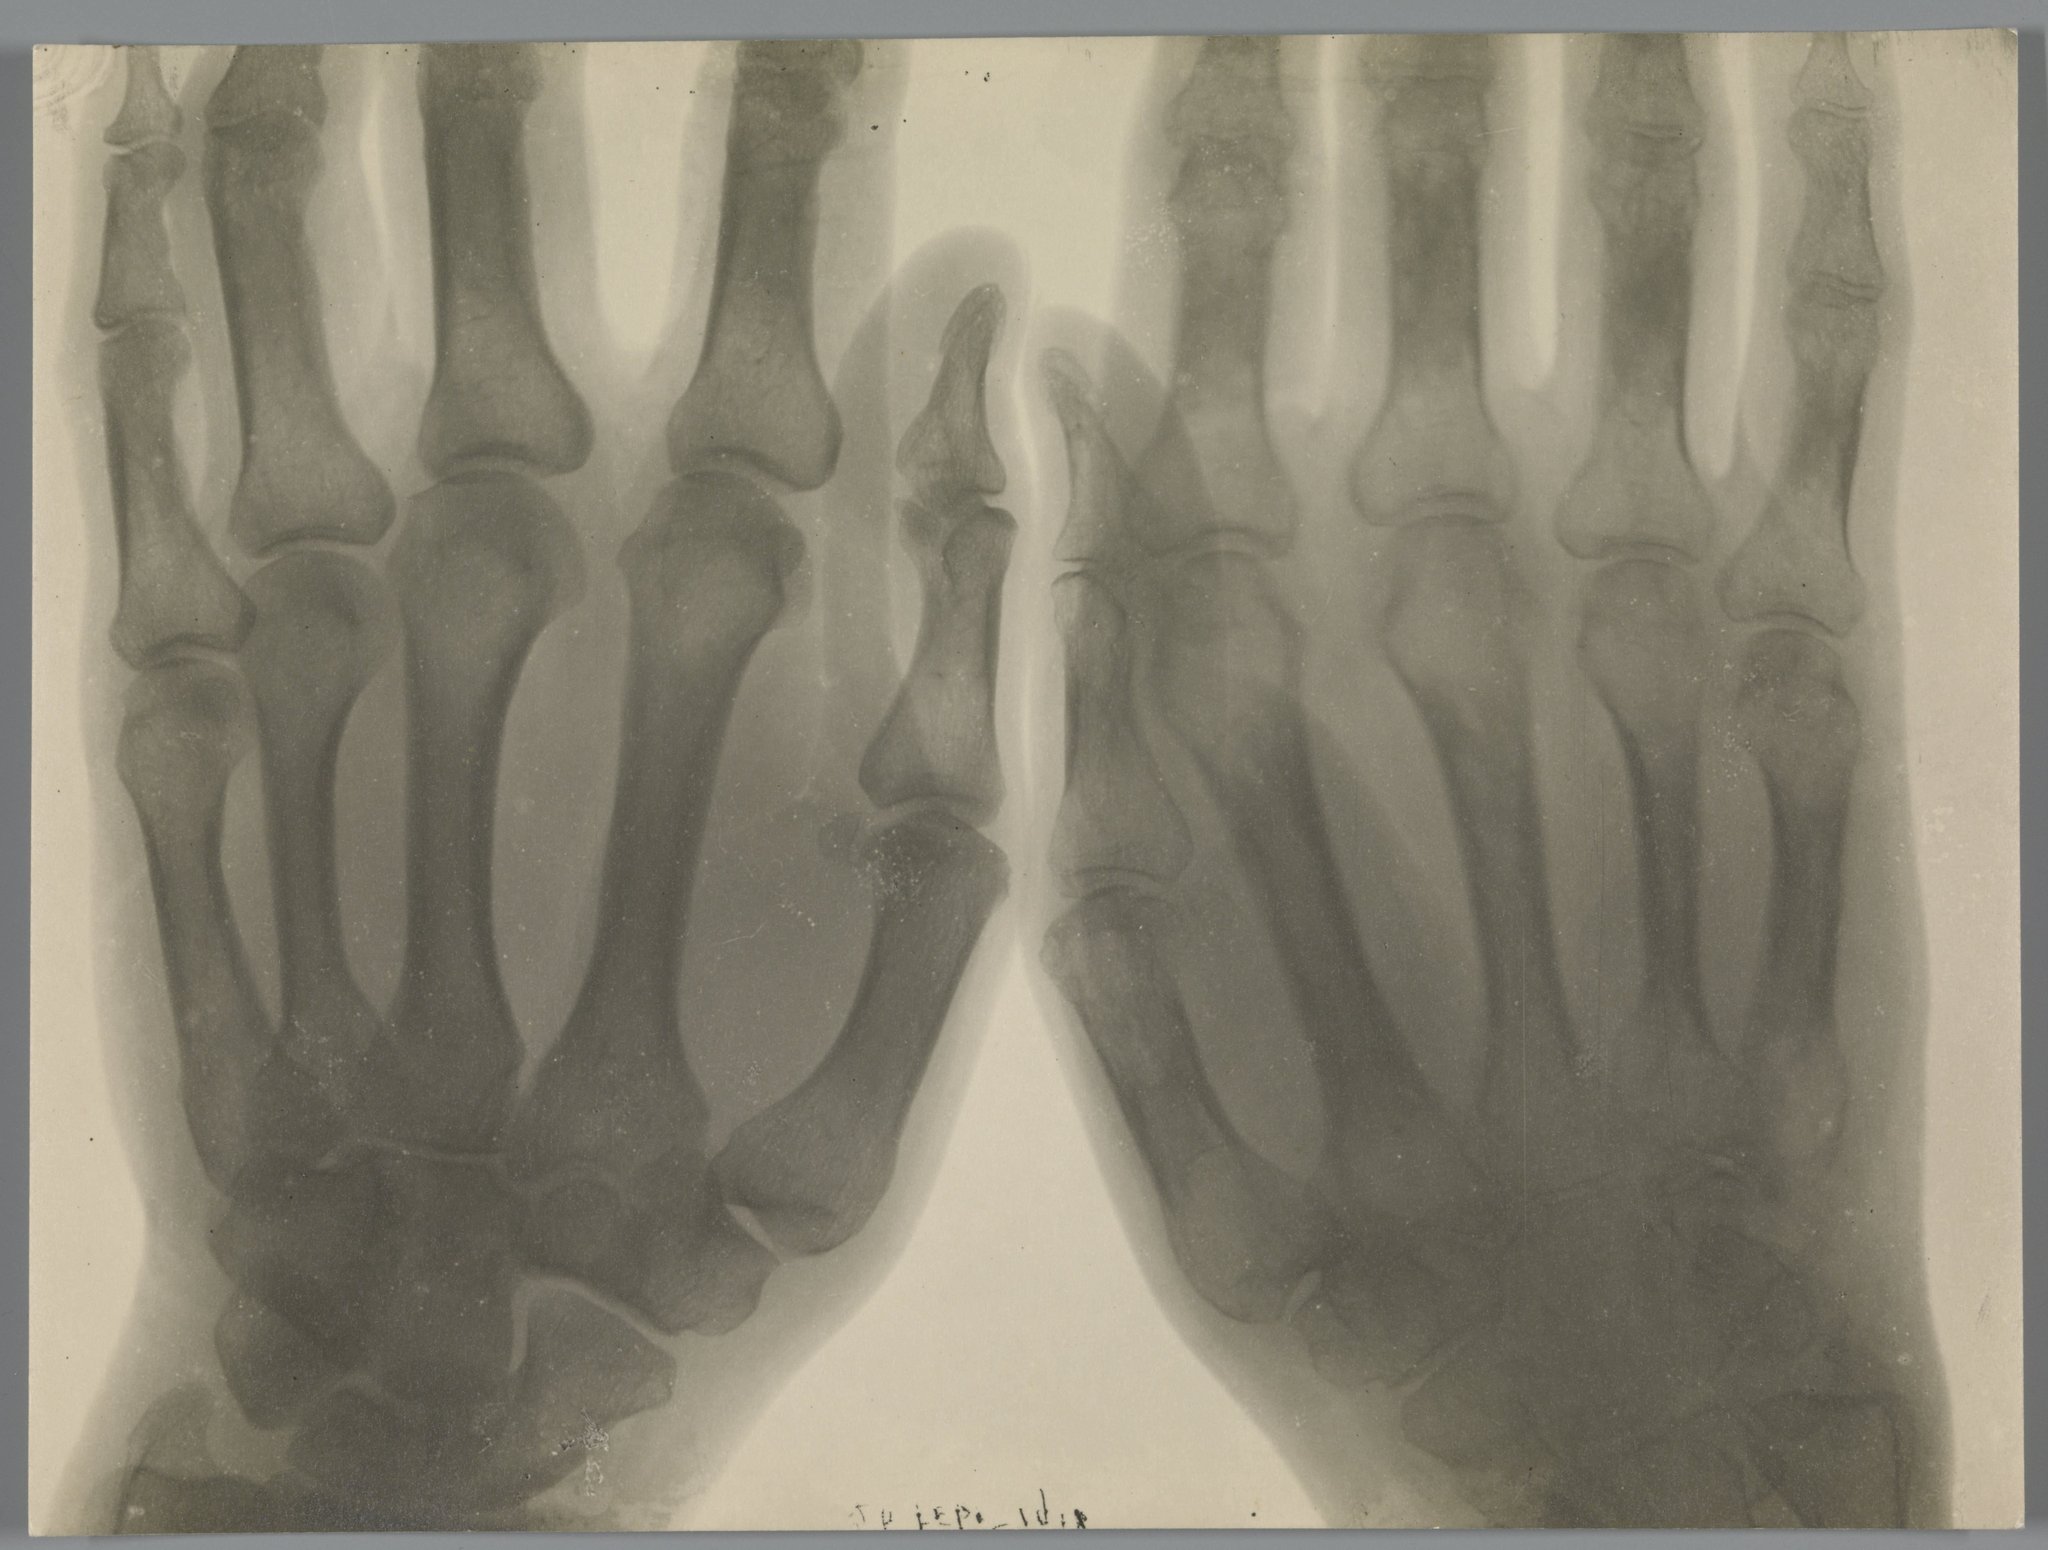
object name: x ray photograph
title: Paar handen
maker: Anonymous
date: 1895-1915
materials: paper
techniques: gelatin silver print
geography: netherlands